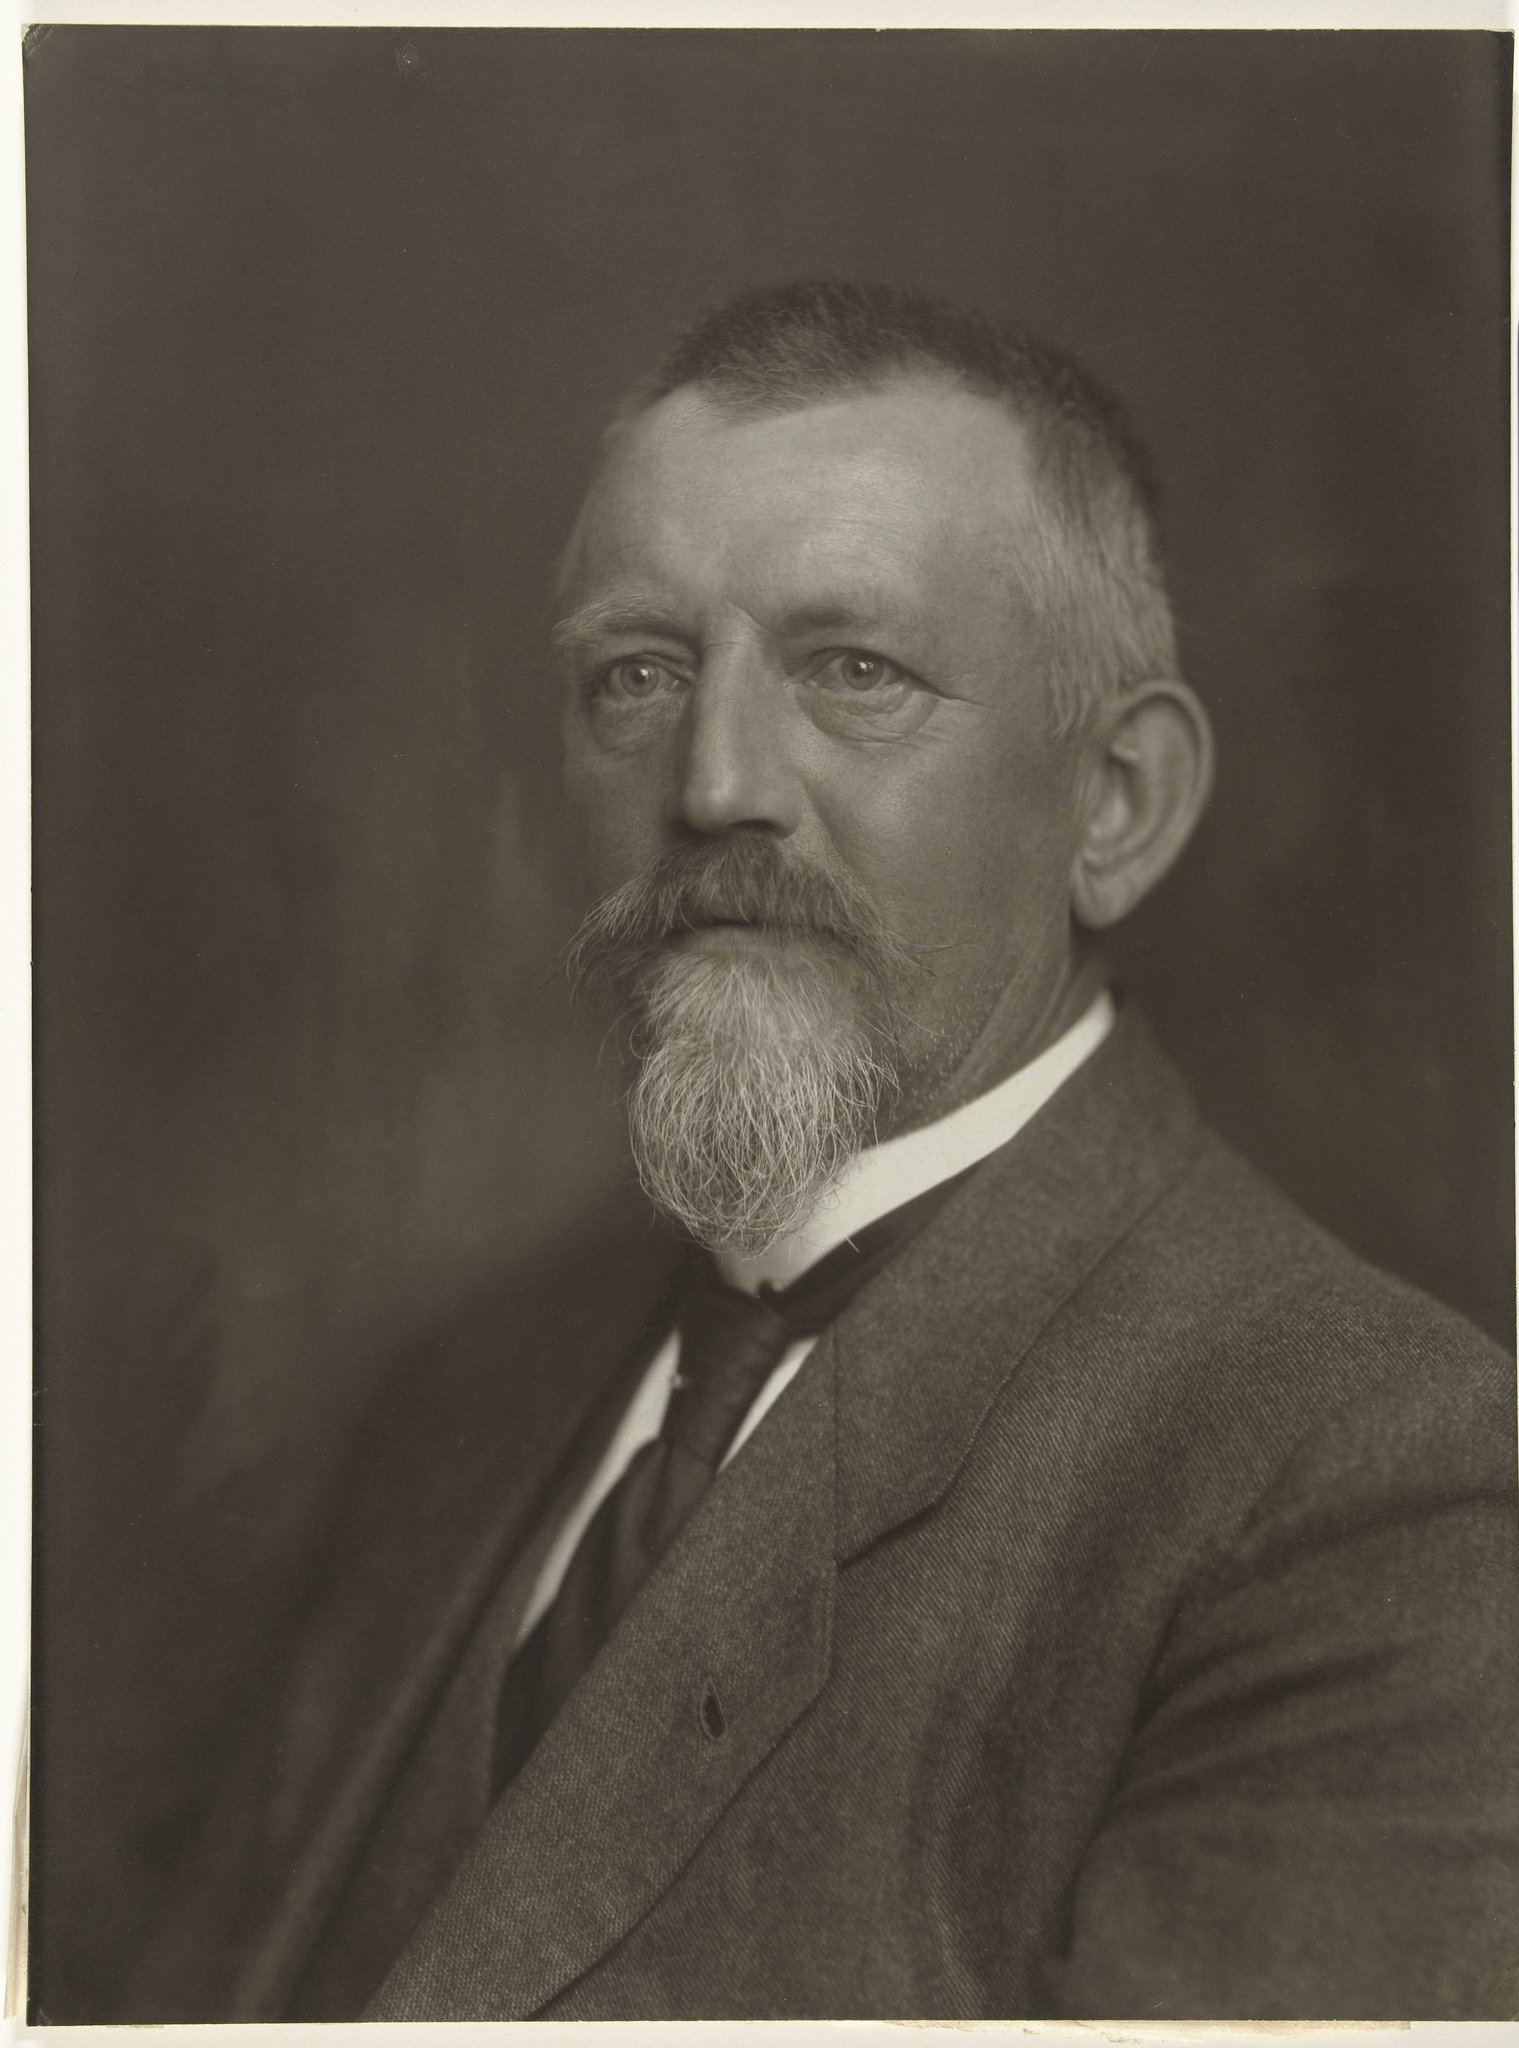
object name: photograph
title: Portret van de Heer Schutte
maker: jacob merkelbach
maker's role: fotograaf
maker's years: 1877-1942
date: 1910-1930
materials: cardboard, paper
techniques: carbon print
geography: amsterdam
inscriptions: annotation: ‘... Schutte, Atelier J. Merkelbach’